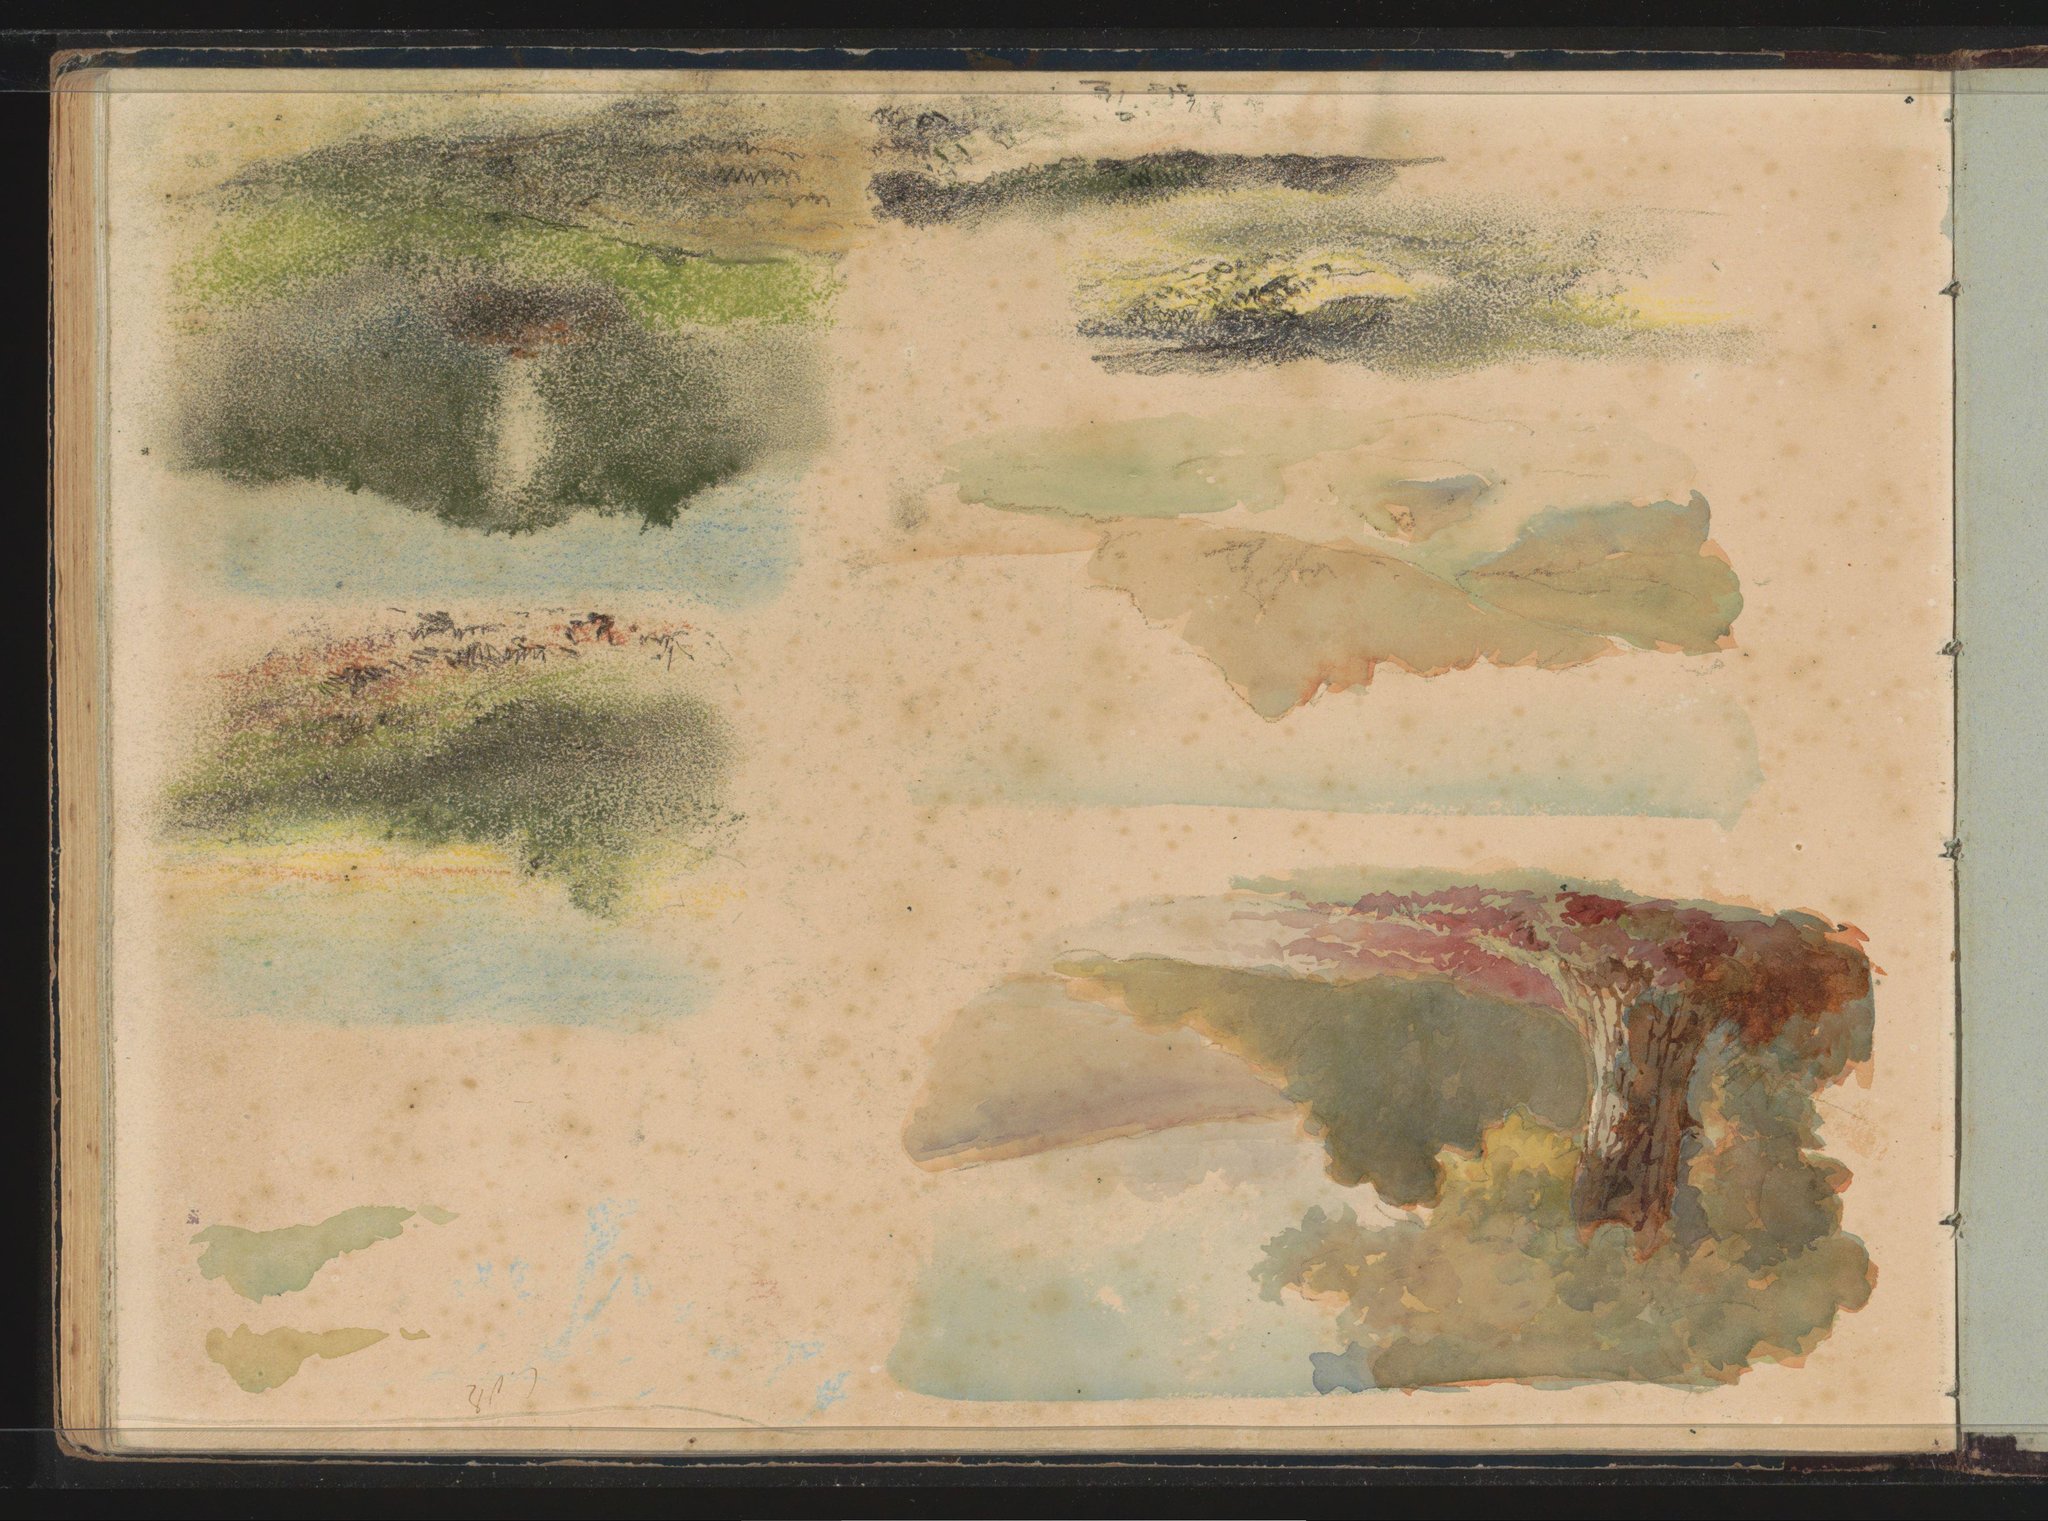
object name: sketchbook leaf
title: Vijf landschappen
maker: maria vos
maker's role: draughtsman, painter, print maker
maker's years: 1824-1906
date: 1864-1865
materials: chalk, paper, pencil, watercolor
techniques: brush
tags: landscapes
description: Blad 43 verso uit een schetsboek met 44 bladen.